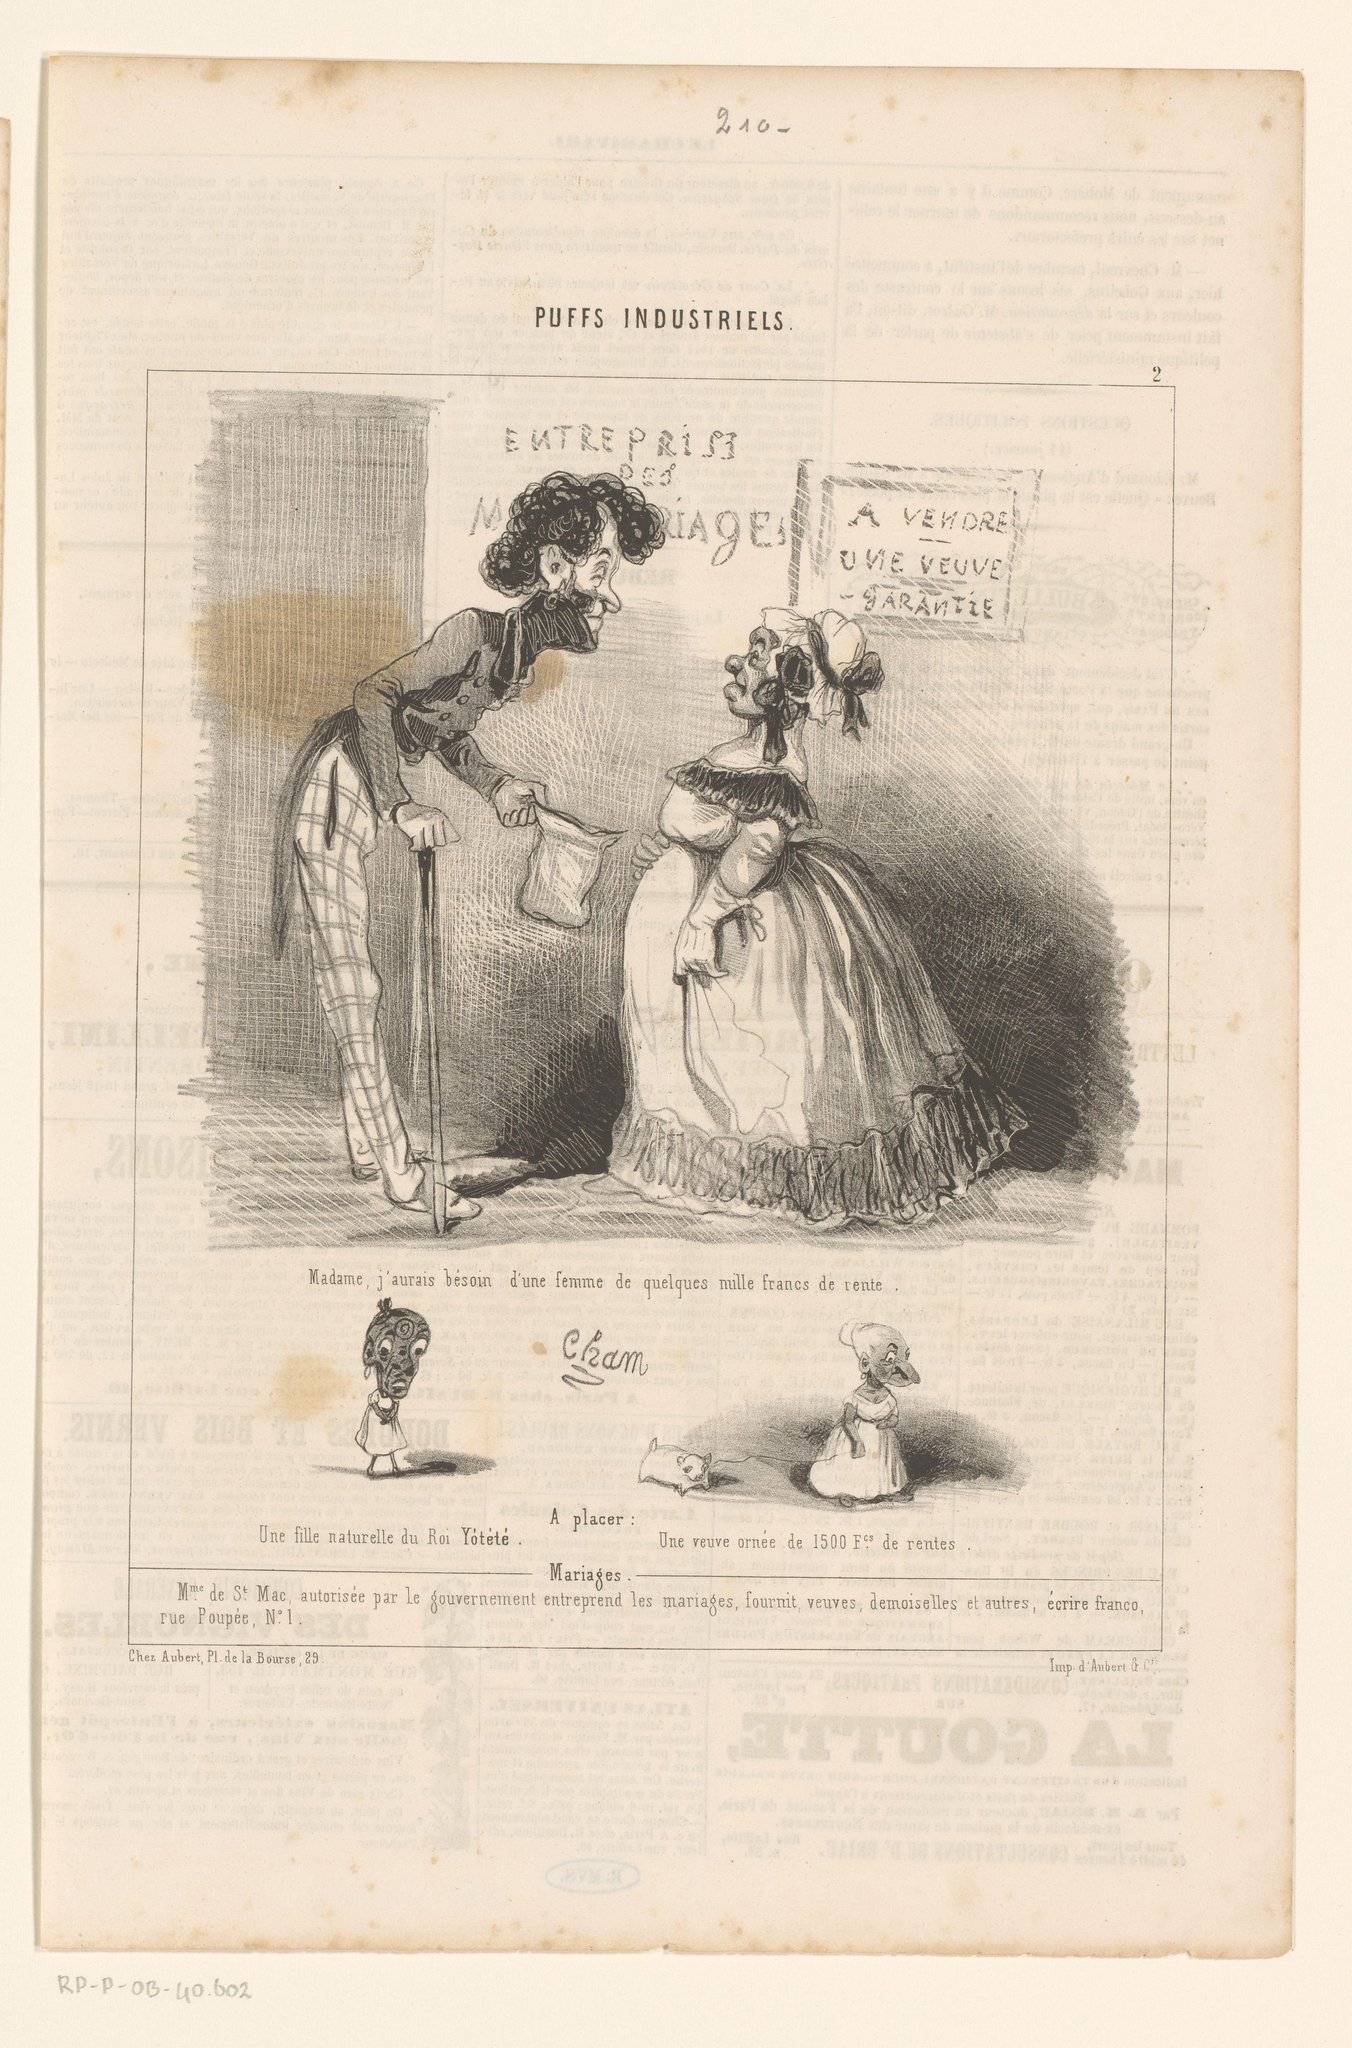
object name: cartoon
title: Man met bedelzak en stok bedelt bij vrouw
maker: cham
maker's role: print maker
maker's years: 1818-1879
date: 1844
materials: paper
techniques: letterpress printing, lithograph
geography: paris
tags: walking-stick, staff, female sex; woman, adult man, begging bowl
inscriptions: collector's mark: Lugt 2228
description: Prent uit: Le Charivari 13 (1844), nr. 12, 12 januari 1844.